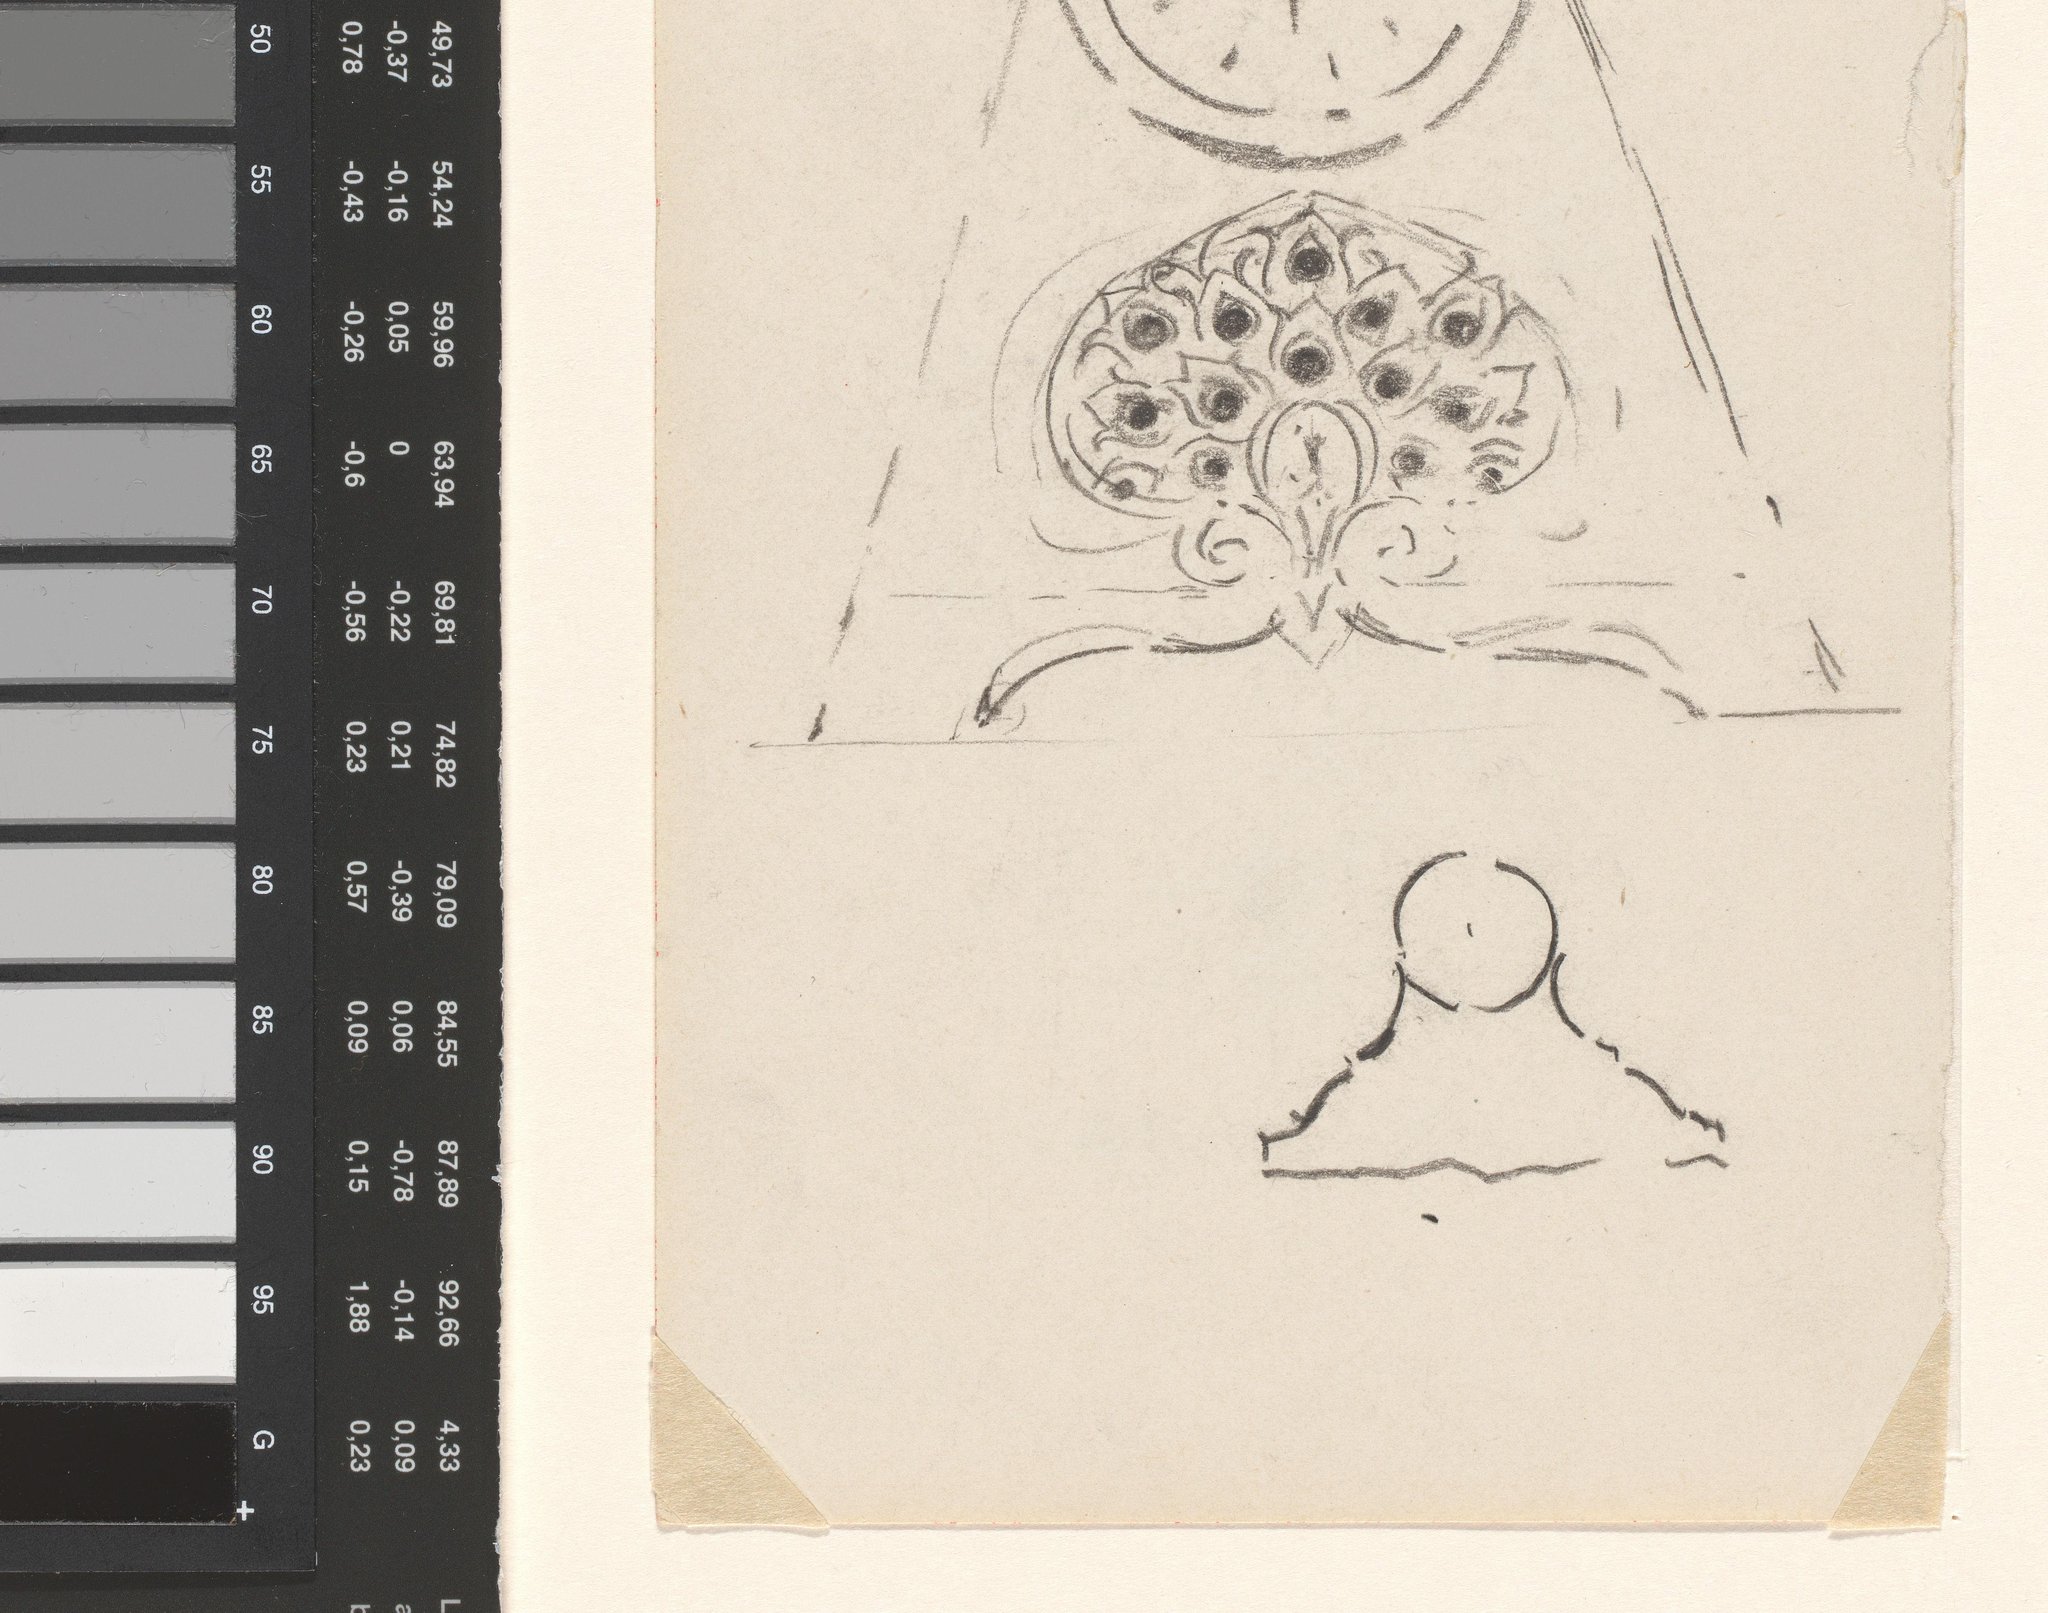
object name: design drawing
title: Ontwerpen voor twee pendules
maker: gerrit willem dijsselhof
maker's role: designer, draughtsman, print maker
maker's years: 1866-1924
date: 1881-1924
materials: chalk, paper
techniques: drawing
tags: clock